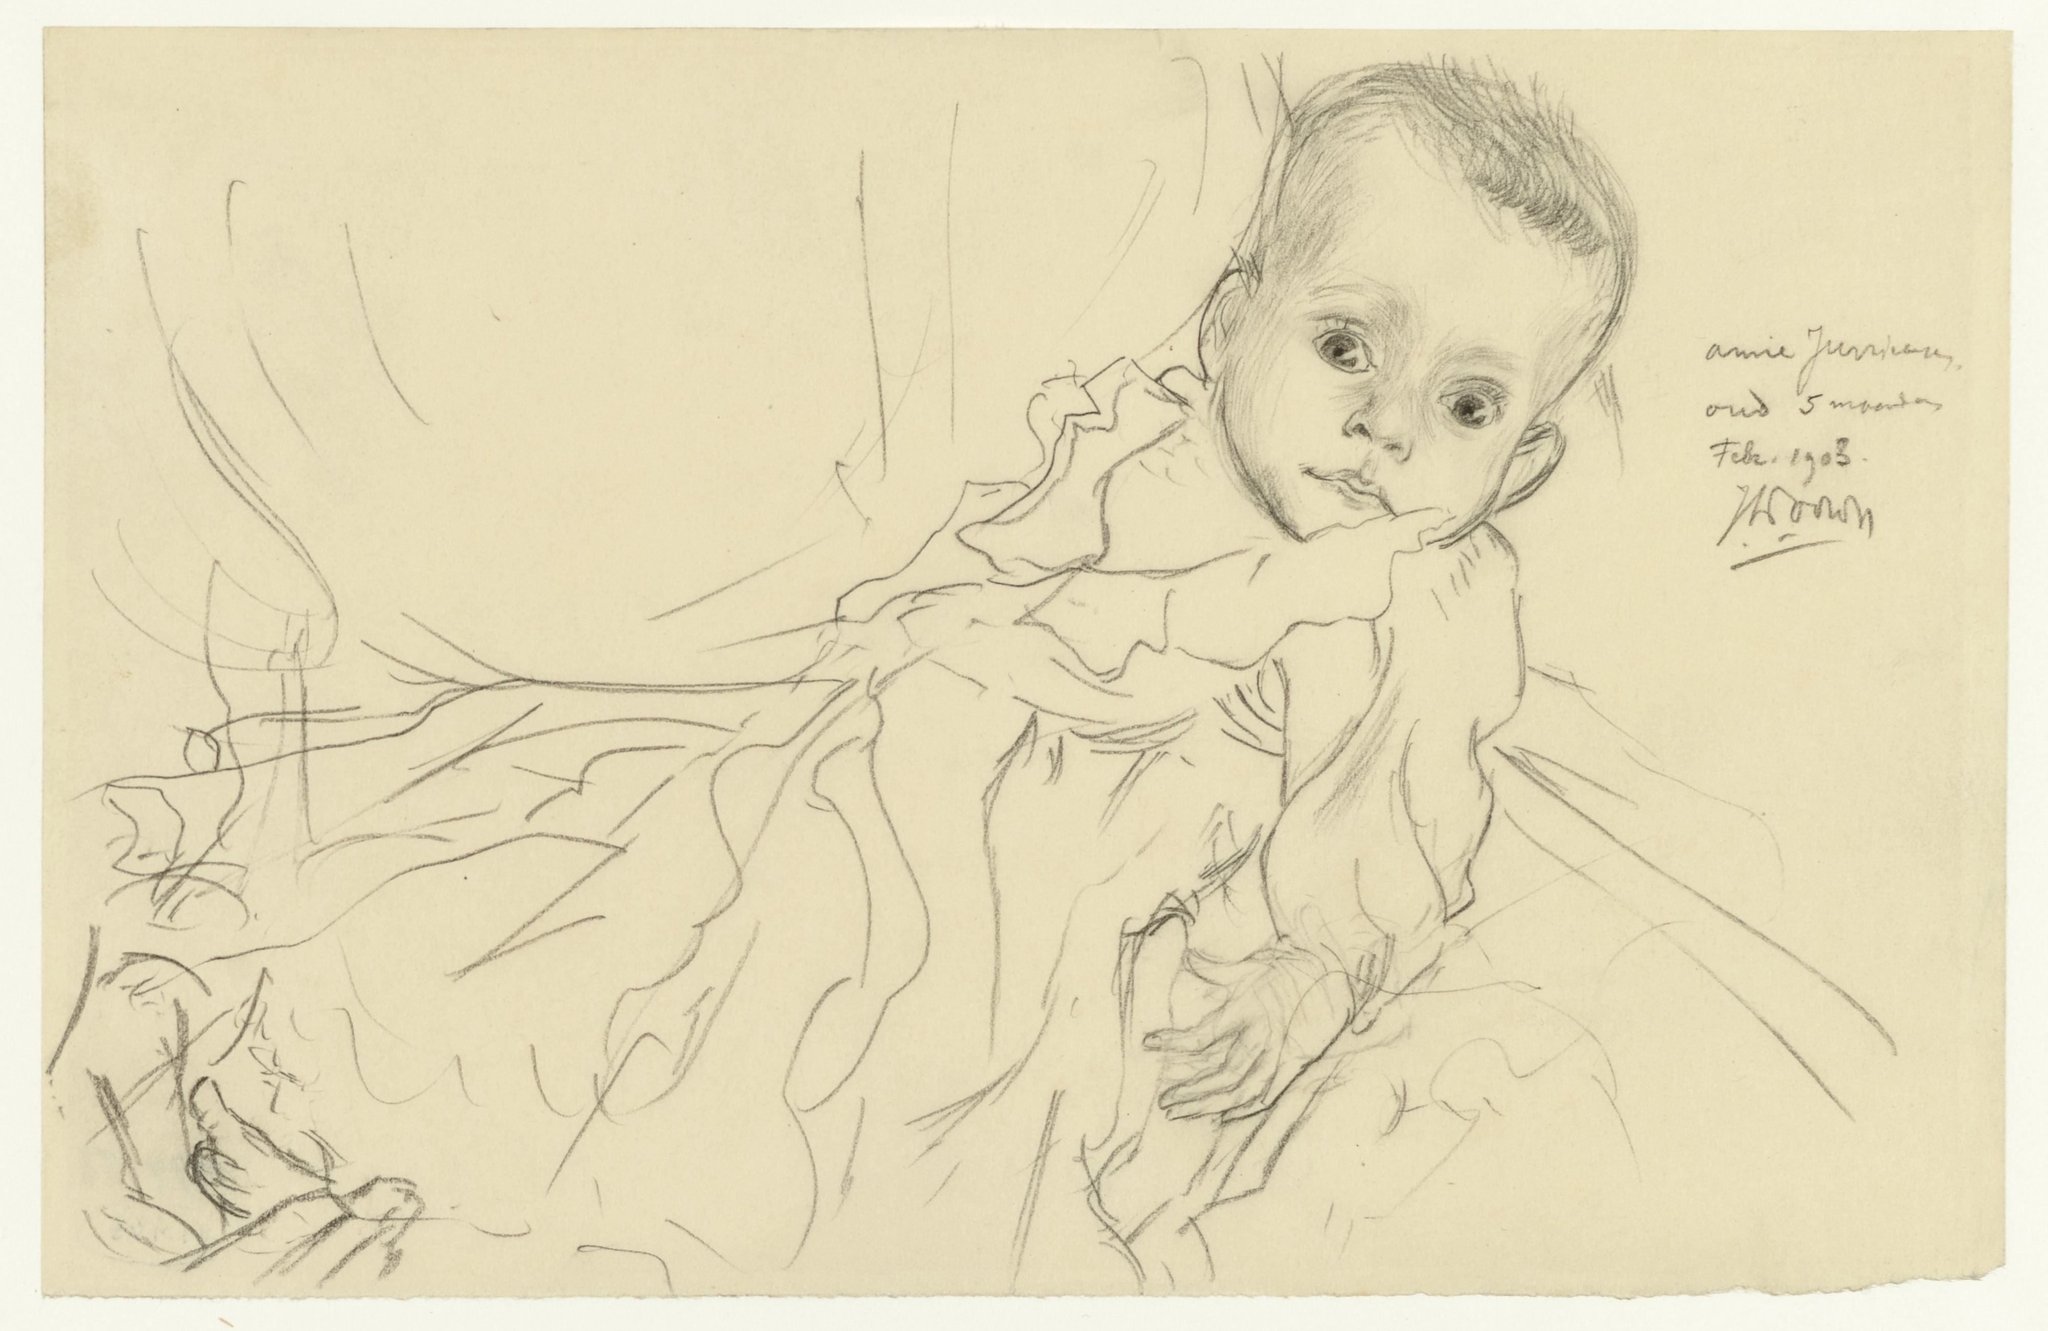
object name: drawing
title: Portret van vijf maanden oude baby Annie Jurriaanse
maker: jan toorop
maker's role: draughtsman, painter, print maker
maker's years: 1858-1928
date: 1902-1903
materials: chalk, paper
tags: historical persons